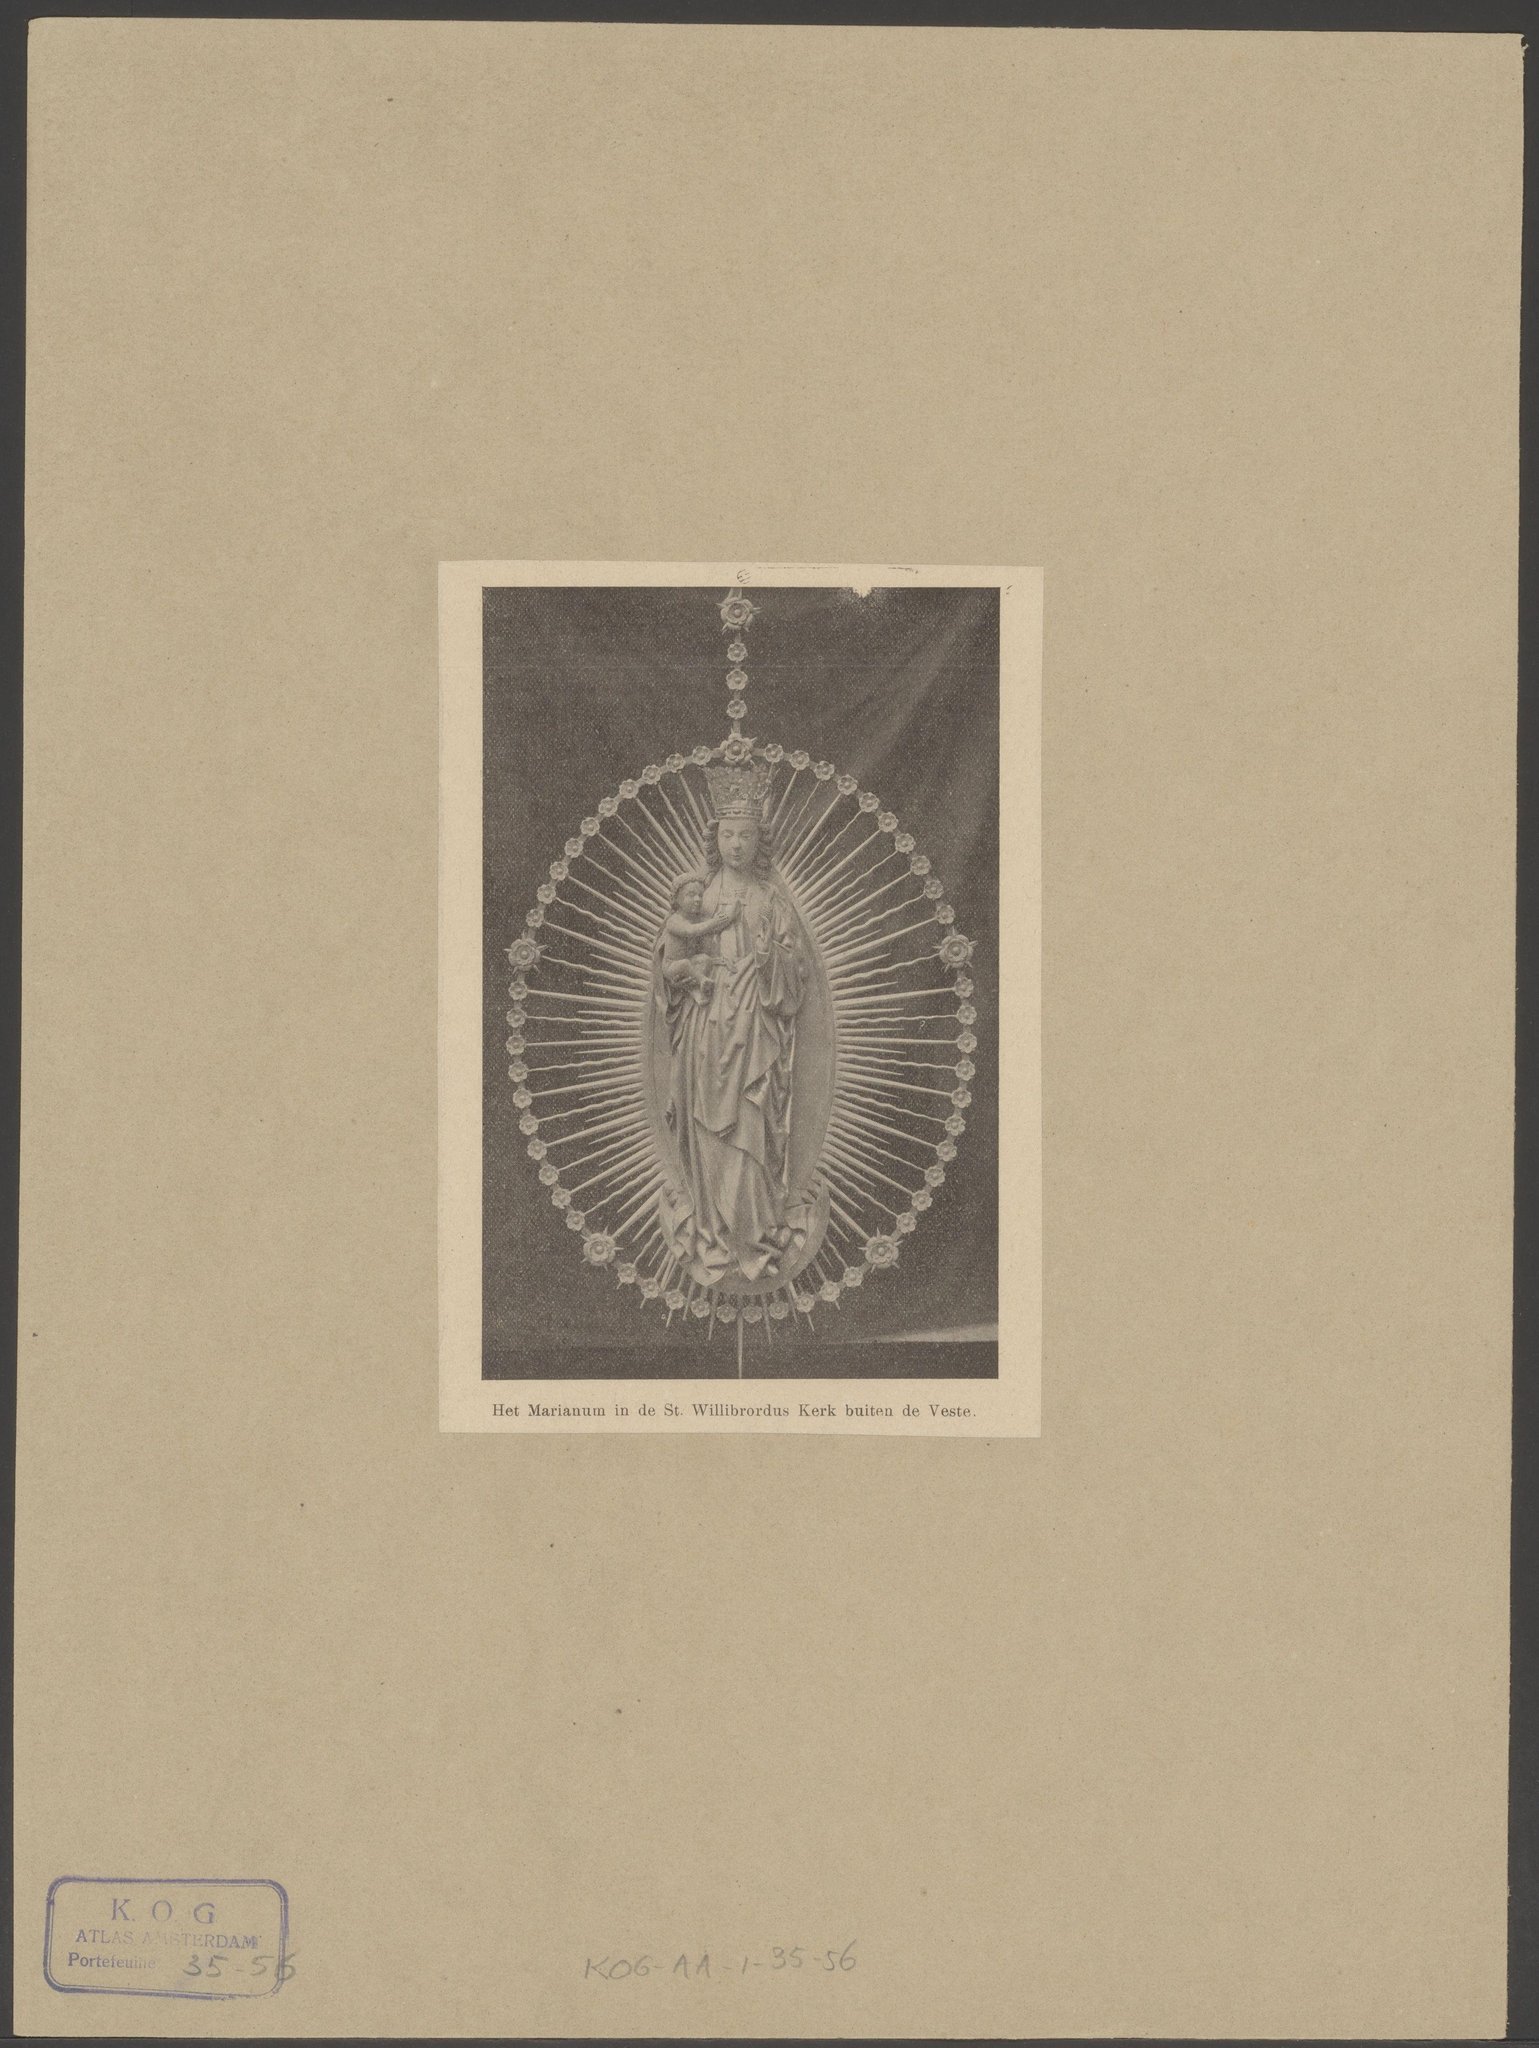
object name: newspaper clipping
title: Marianum de Sint-Willibrorduskerk buiten de Veste te Amsterdam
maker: Anonymous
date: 1900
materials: paper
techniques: letterpress printing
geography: amsterdam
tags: 'marianum', madonna in aureole or mandorla (surrounded by the rosary), mary in the glory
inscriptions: collector's mark: ‘35-56’ Lugt 1641b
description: Geknipt uit: Geïllustreerd Zondagsblad voor Katholieken (1900). Onderwerpsrubriek binnen de Atlas Amsterdam: R.K. Gemeenten: Sint Nicolaaskerk t/m Willibrordus (Rustenburgerstraat).